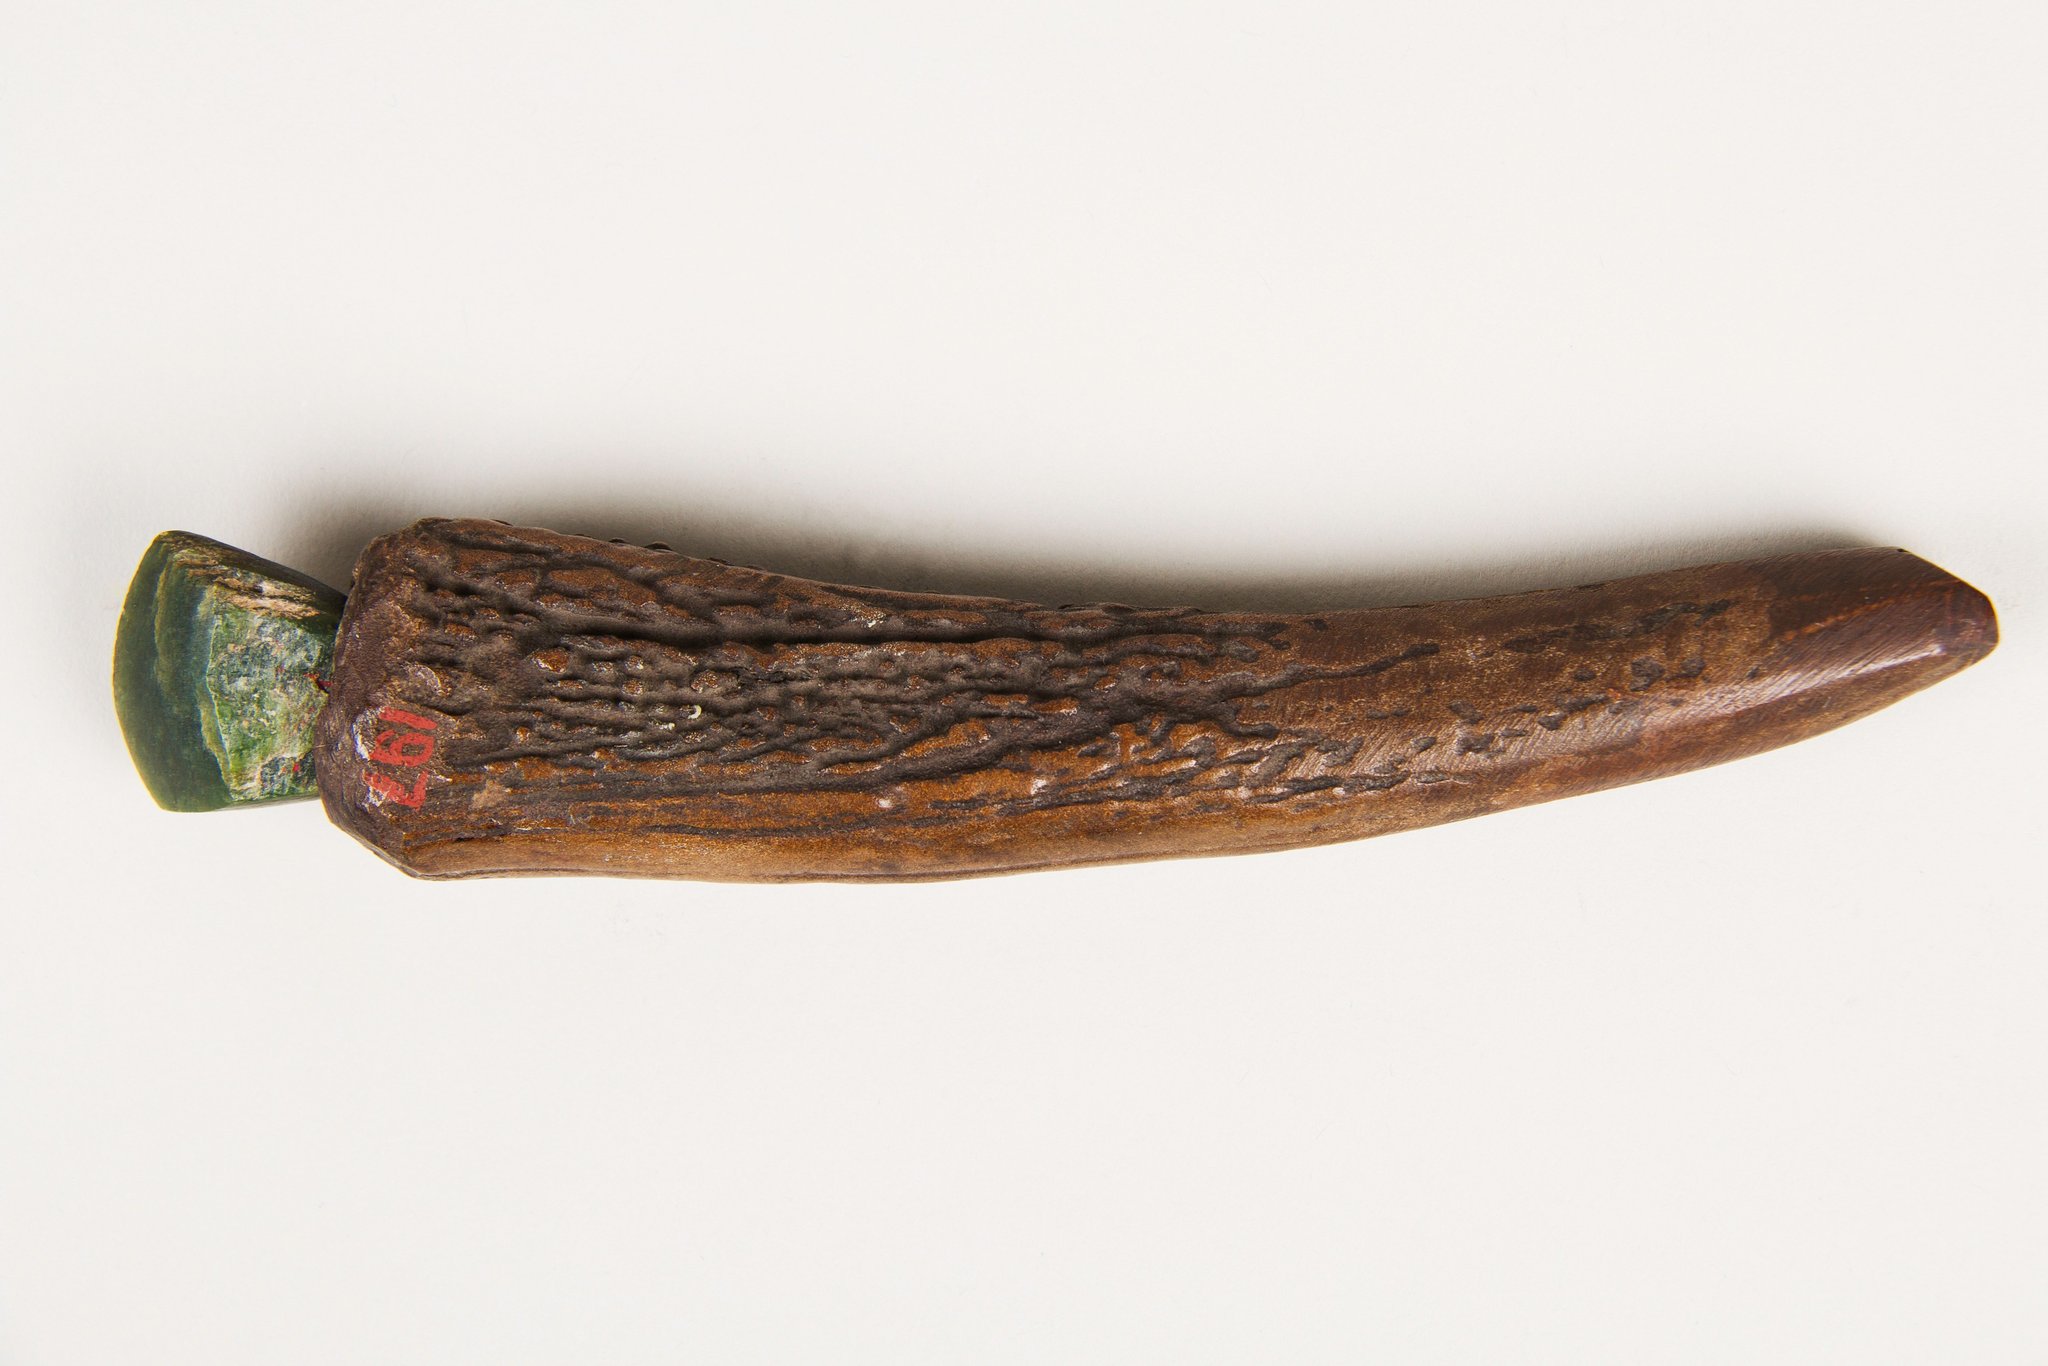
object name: knife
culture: swiss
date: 1902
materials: jade